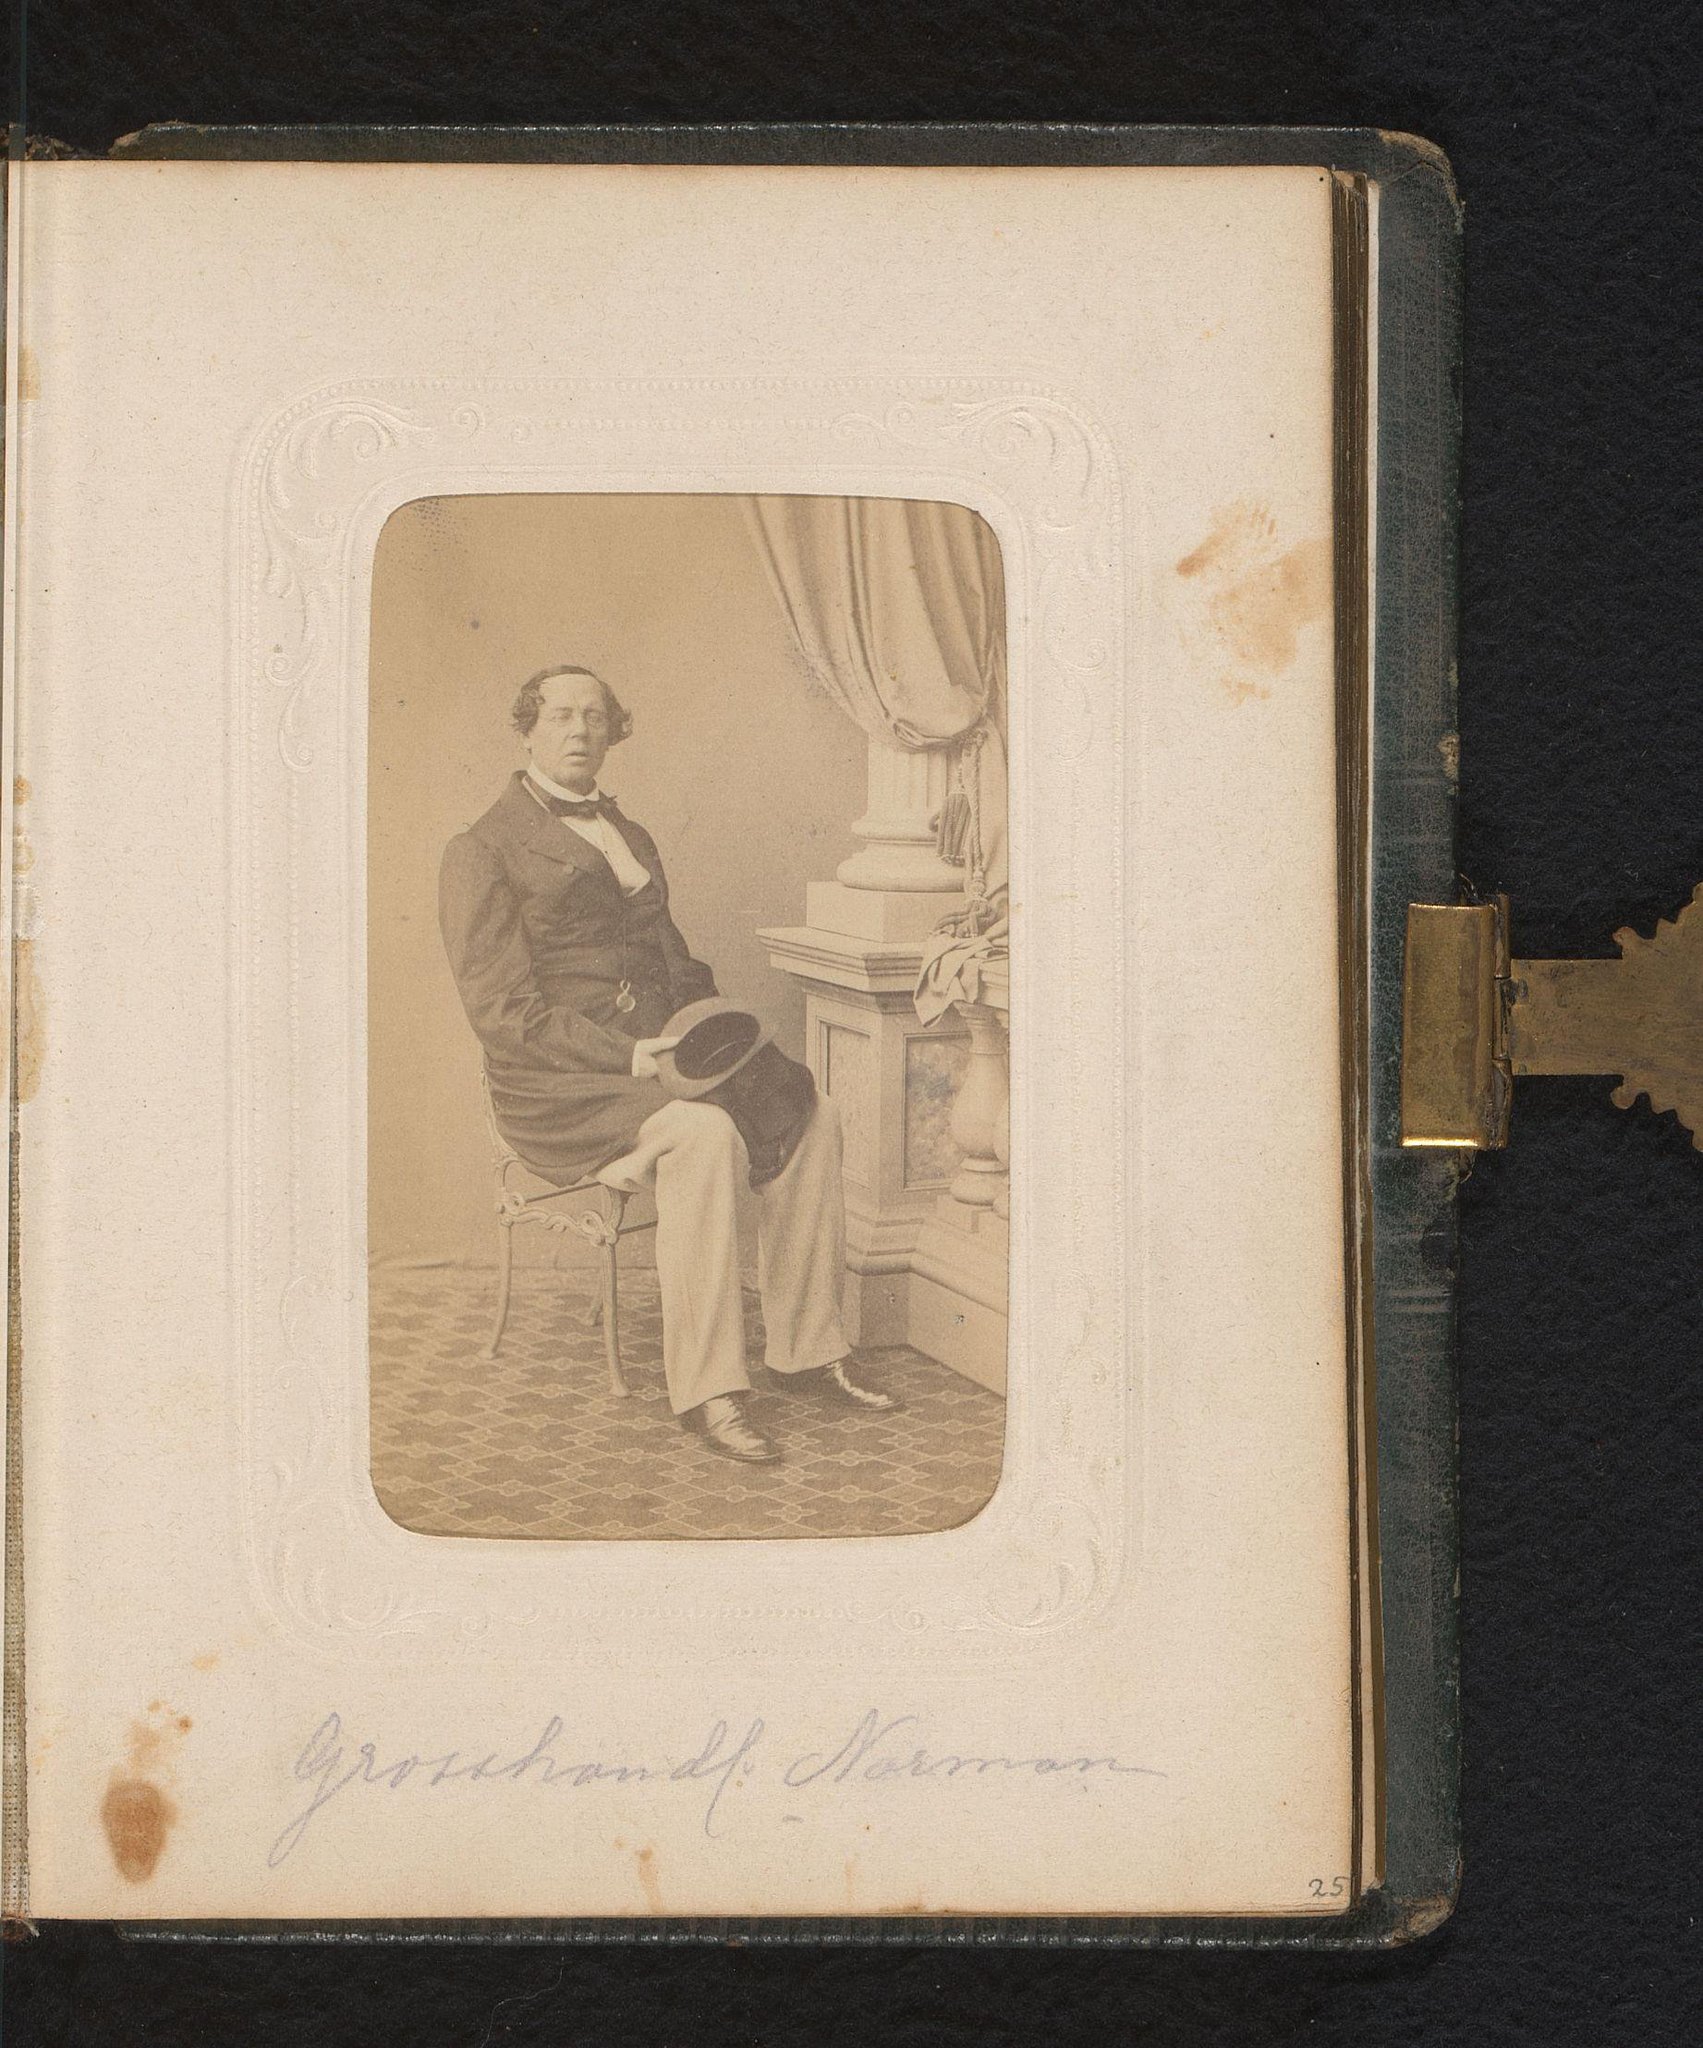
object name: carte de visite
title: Portret van een zittende man met hoge hoed in de hand, aangeduid als Norman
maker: Anonymous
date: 1860-1900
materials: cardboard, photographic support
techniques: albumen print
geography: sweden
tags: sitting figure, historical persons, head-gear: top hat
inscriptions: name: ‘Grosshandl. Norman’, annotation: ‘f.d. Grosshandlaren/ n. m. Rassören Norman/ frå Skarhutt; Skåne’